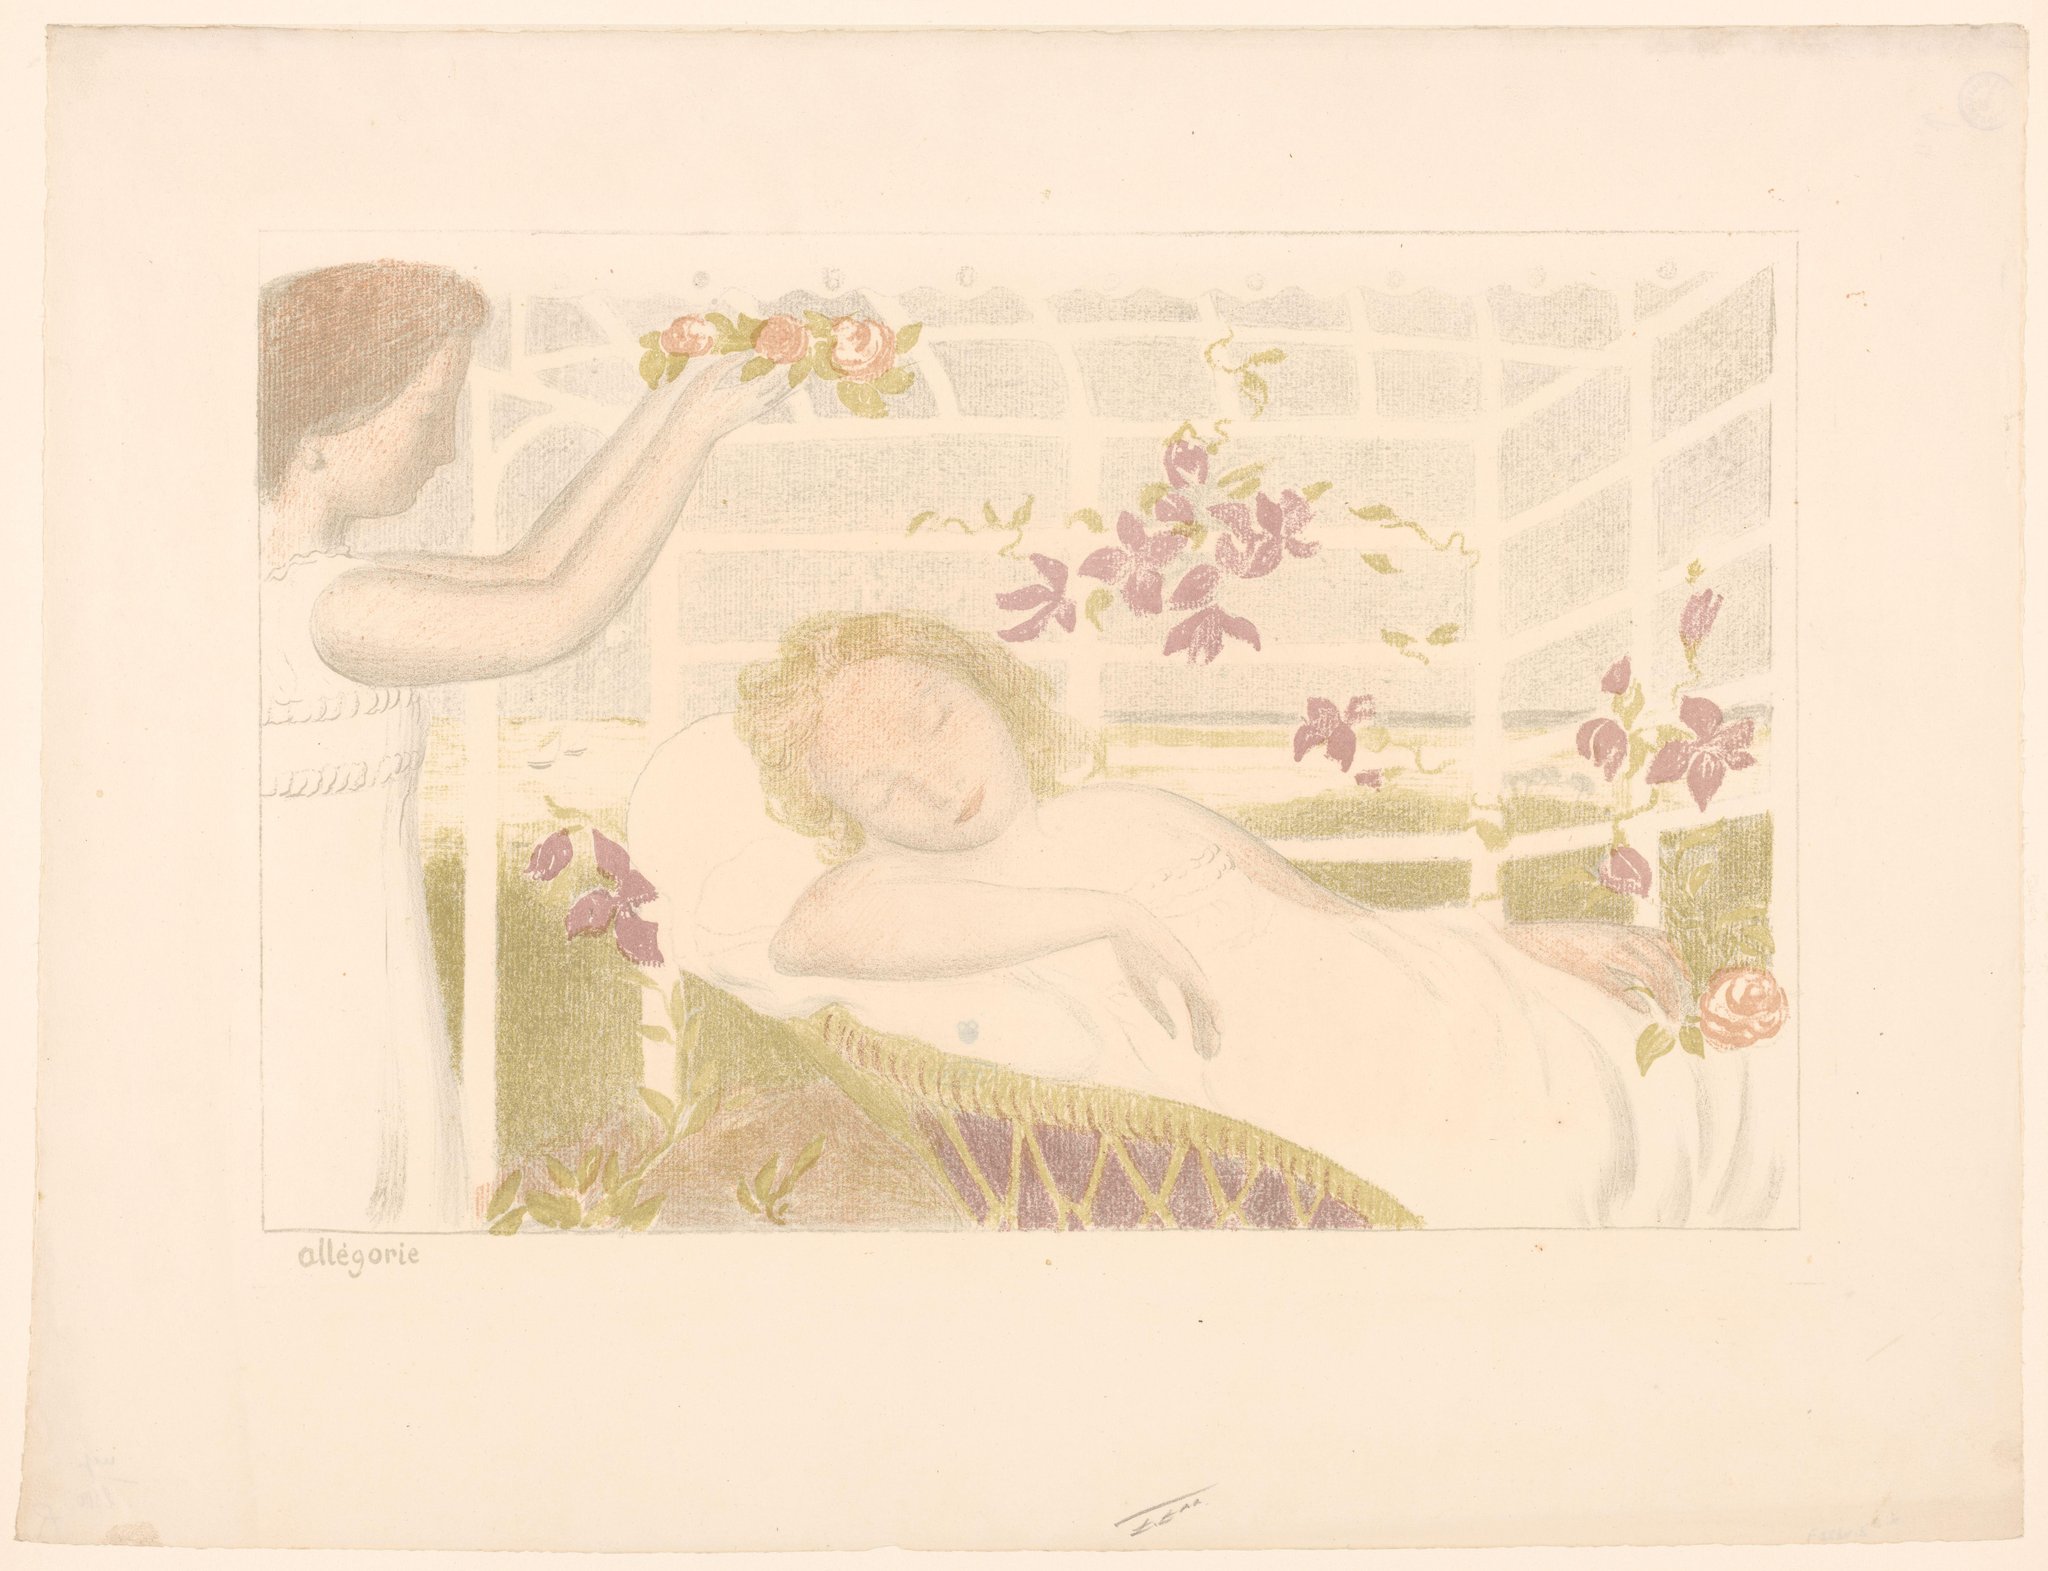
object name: print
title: Amour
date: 1899-1911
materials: paper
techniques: lithograph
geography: paris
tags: adolescent, young woman, maiden, sleeping in chair, garland, wreath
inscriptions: collector's mark: Lugt 2760, collector's mark: Lugt 2228a, stamp: ‘Expositions douanes Paris’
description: Dit is de eerste prent uit een serie van twaalf.